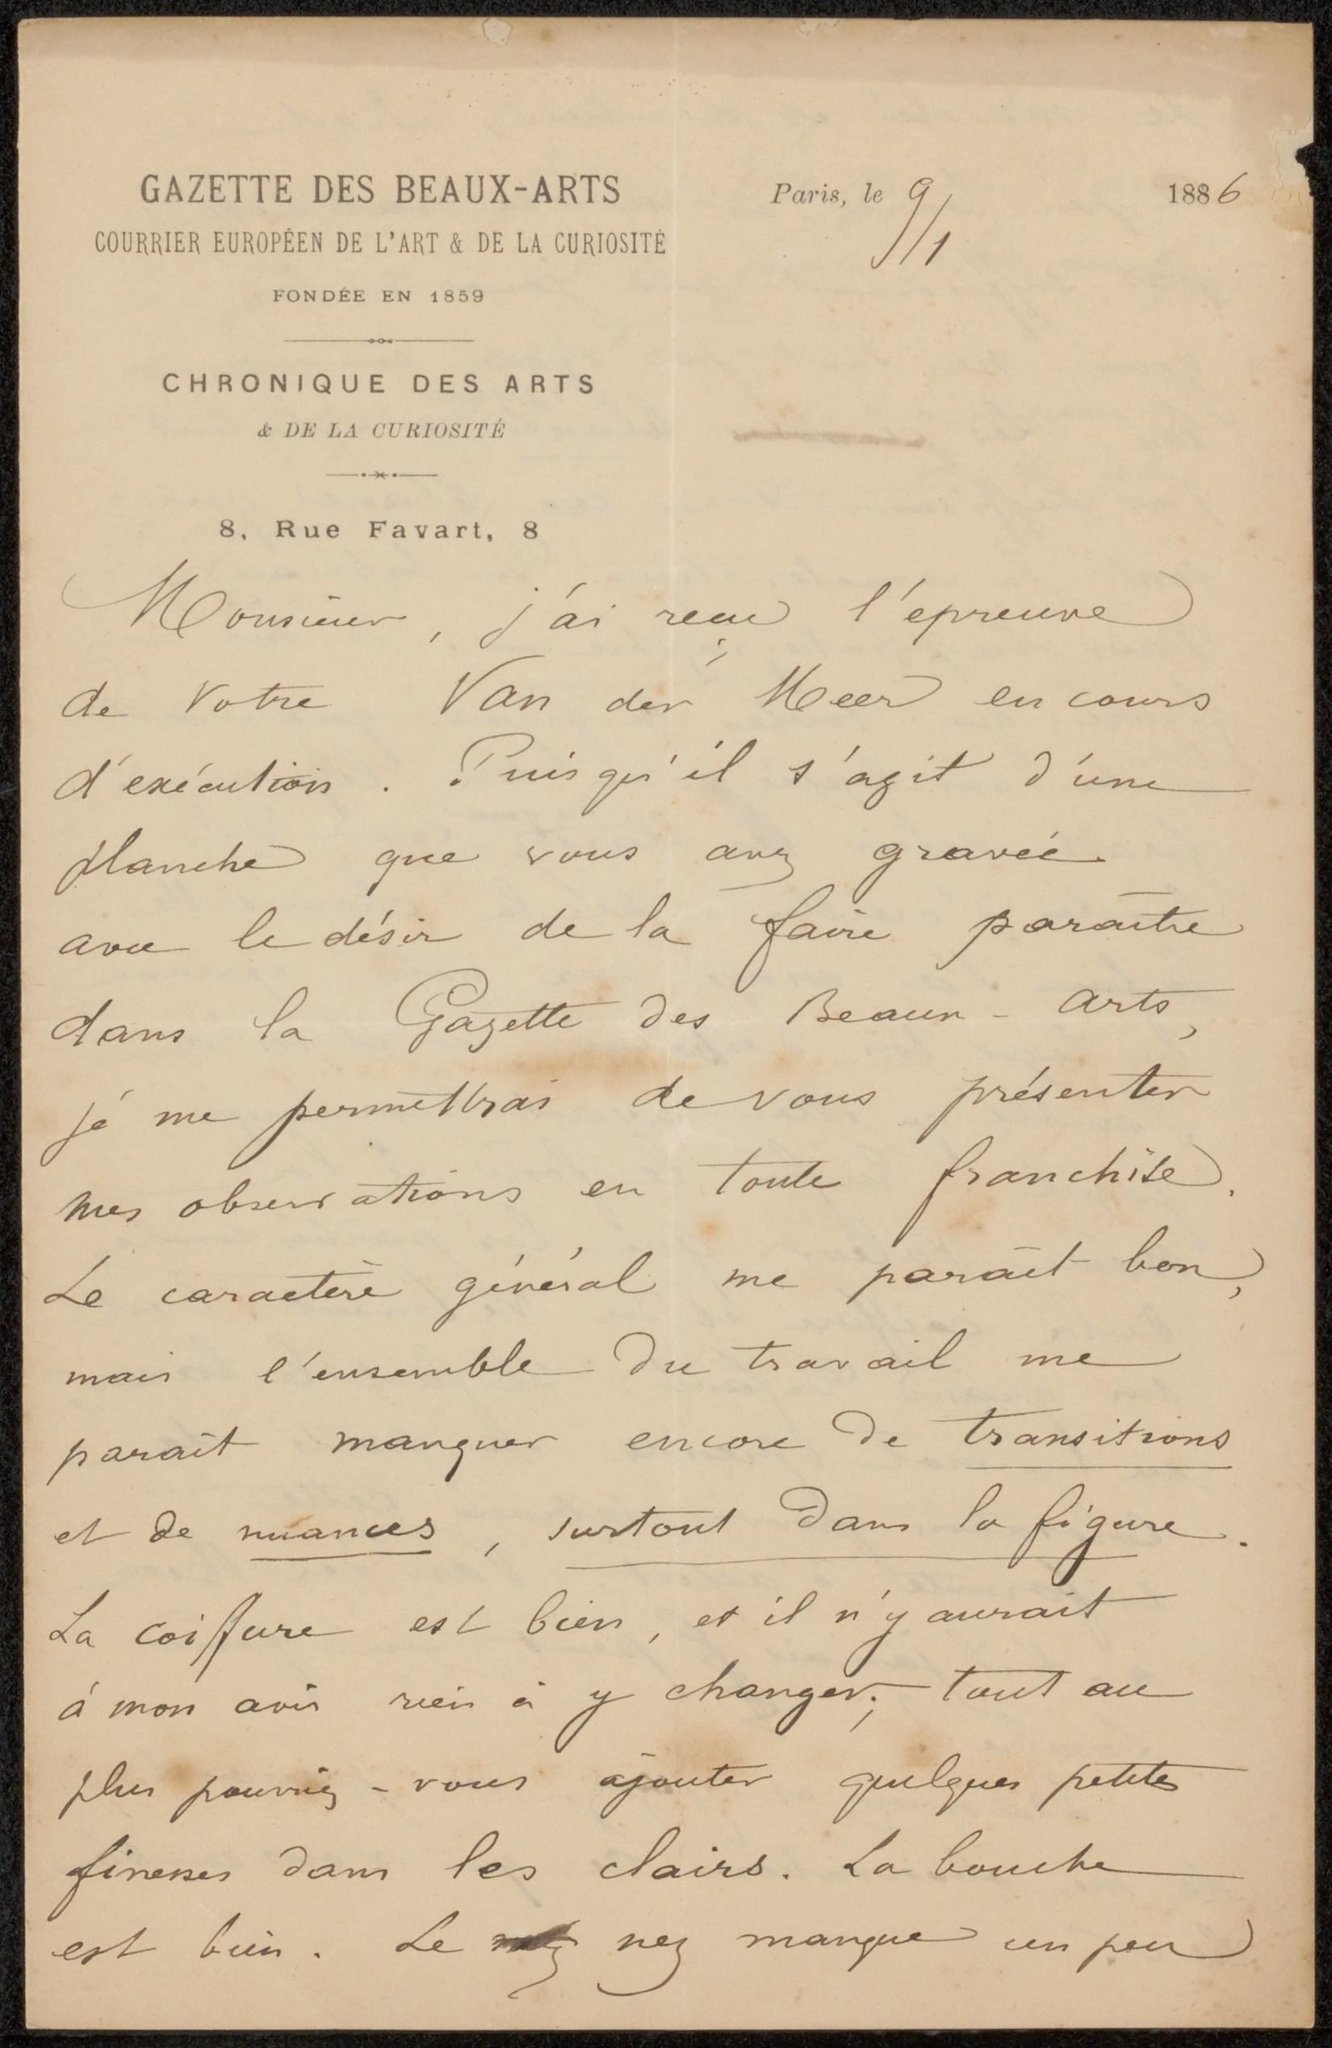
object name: letter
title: Brief aan Philip Zilcken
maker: louis gonse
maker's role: kunsthistoricus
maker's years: 1846-1921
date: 1886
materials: ink, paper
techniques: pen, printing, writing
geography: paris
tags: the hague, painter, draughtsman, philip zilcken, photography, cinematography, painting (including book-illumination, miniature-painting)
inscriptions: collector's mark: ‘RPK’